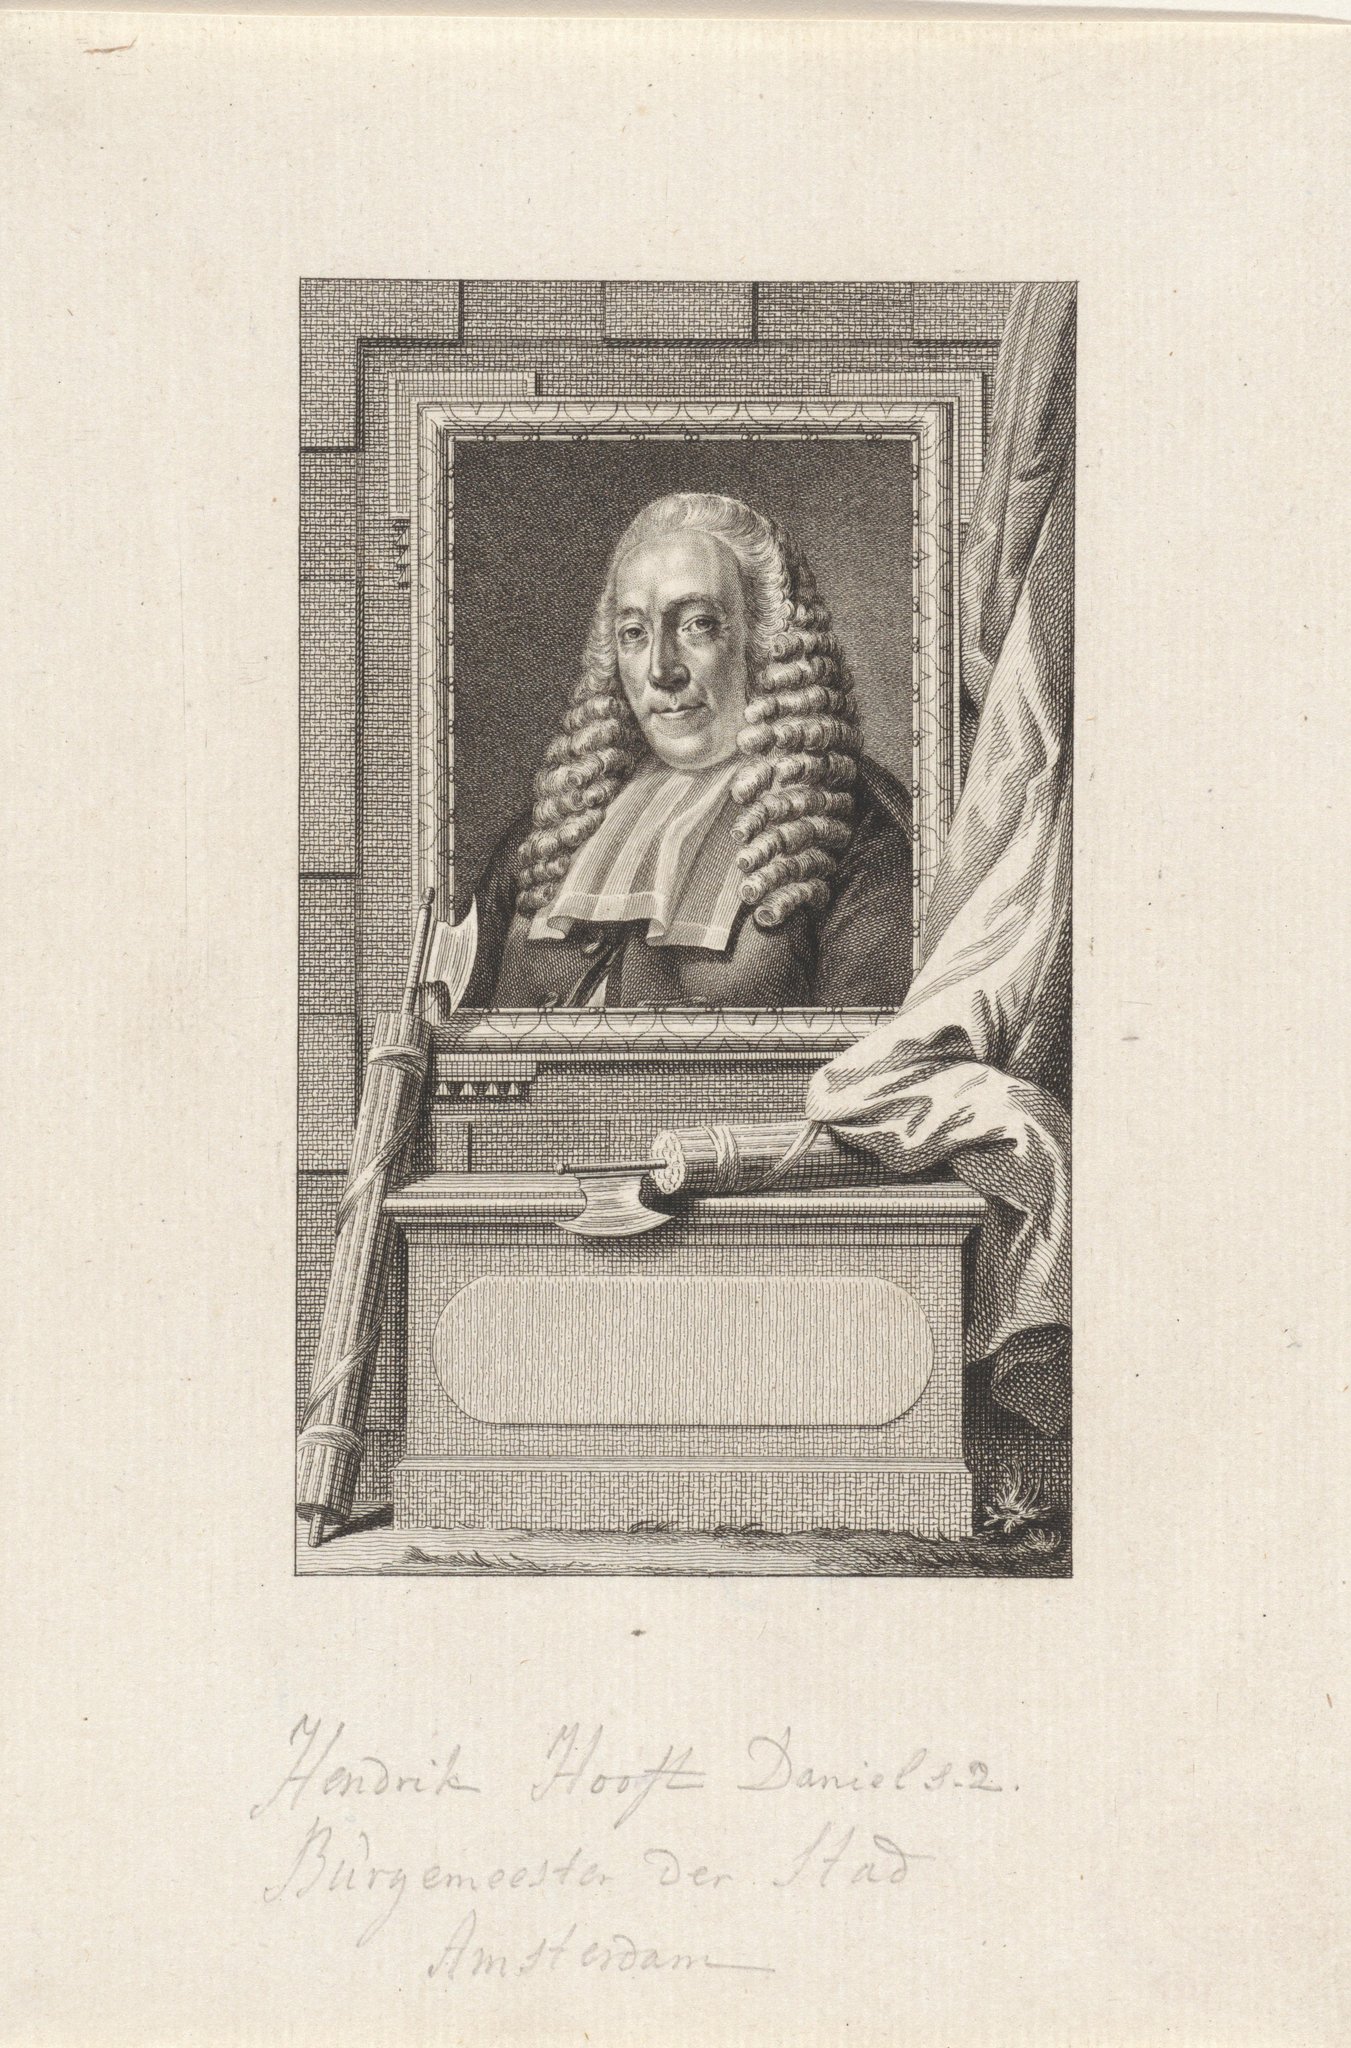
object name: print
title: Portret van Hendrik Danielsz. Hooft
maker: reinier vinkeles (i)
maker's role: draughtsman, print maker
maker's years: 1741-1816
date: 1786-1809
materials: paper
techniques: etching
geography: amsterdam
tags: mayor, hendrik danielsz. hooft, symbols and allegories of law; 'legge', 'legge civile' (ripa) (+ 'fasces cum securibus')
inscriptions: collector's mark: Lugt 240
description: Latere staat prent ook gebruikt als boekillustratie in: Wagenaar, Jan. Vaderlandsche historie, (...) ten vervolge van Wagenaars Vaderlandsche historie. Dl. 1-43. Amsterdam: Johannes Allart, 1786-1809.